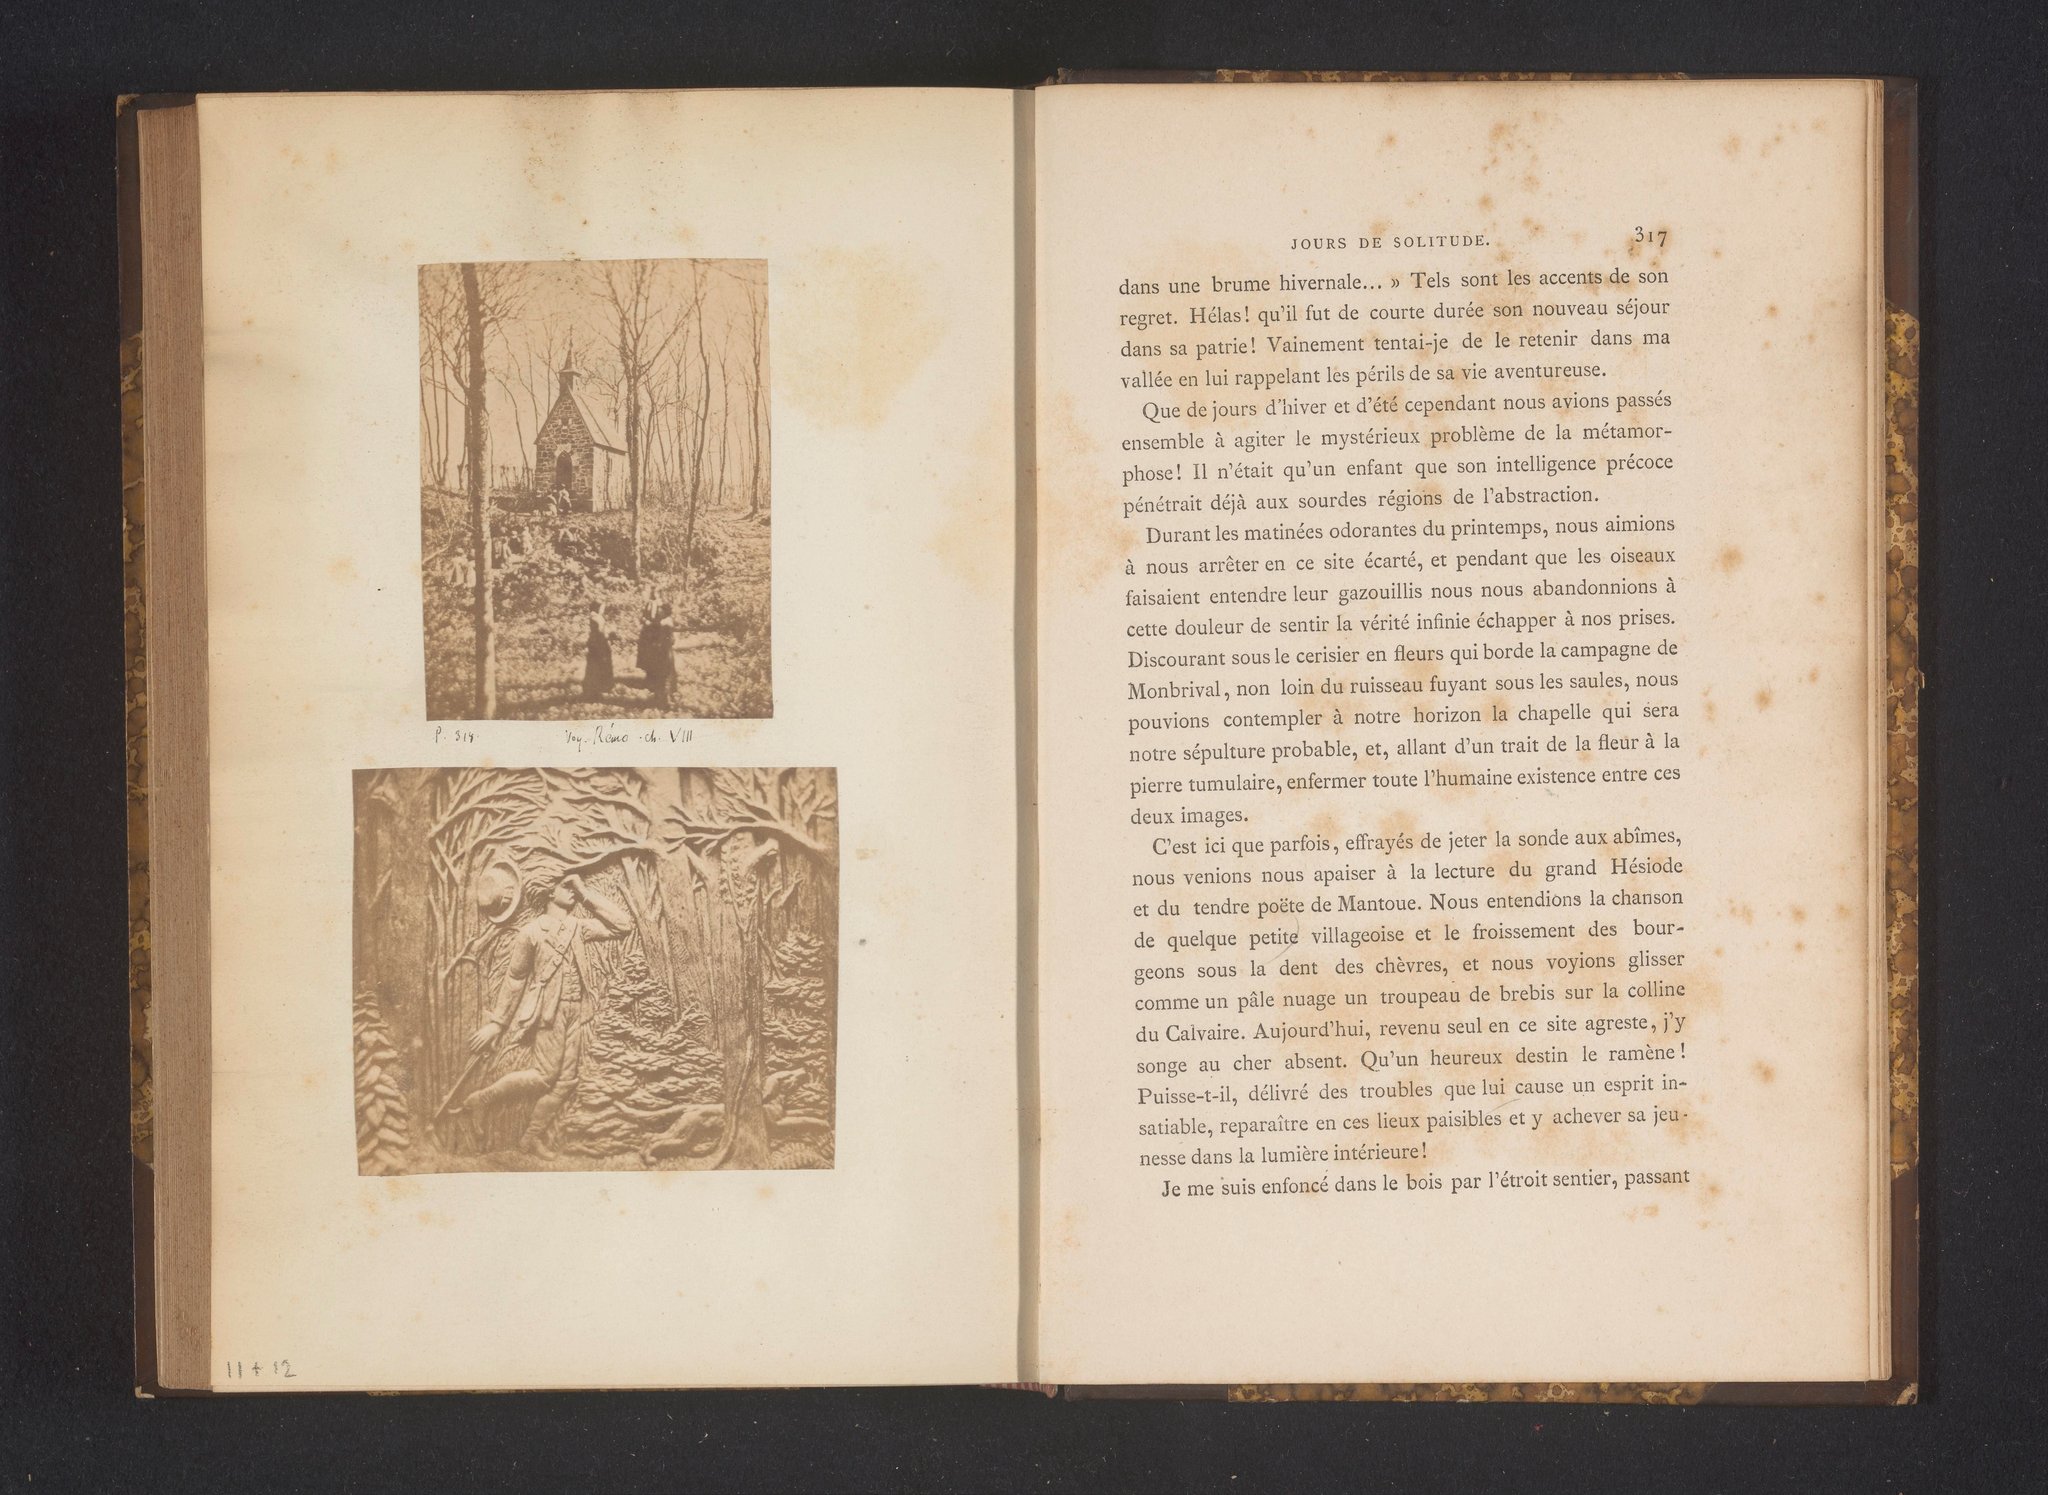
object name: page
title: Reliëf van een jager met hond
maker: Anonymous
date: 1872-1877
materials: photographic support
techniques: albumen print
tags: hunter, dog, belgium